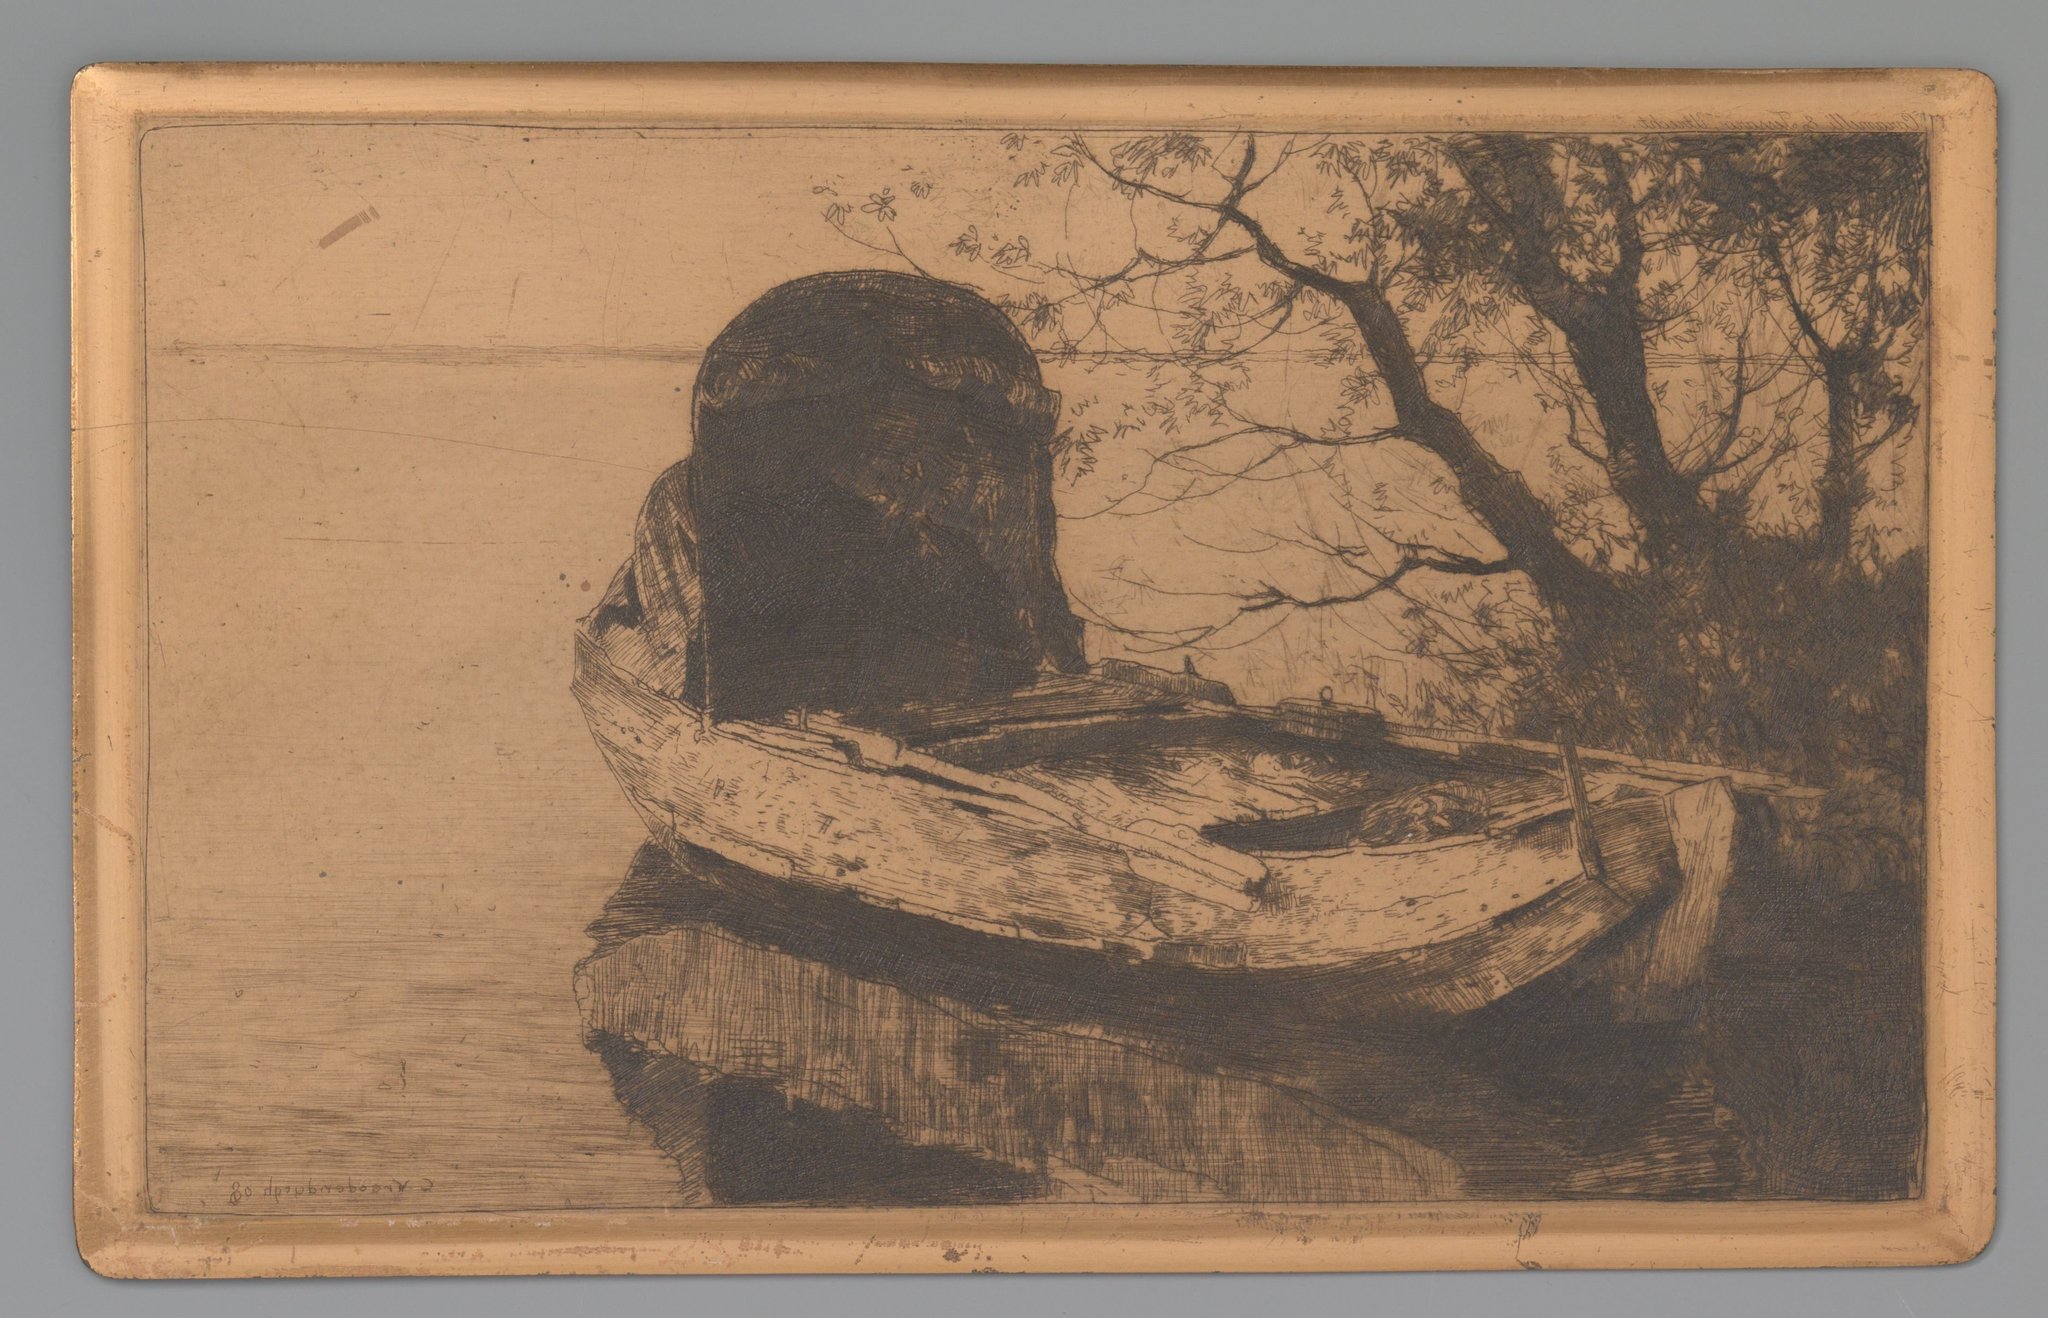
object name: copper plate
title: Boot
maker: cornelis vreedenburgh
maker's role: draughtsman, print maker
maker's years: 1880-1946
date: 1908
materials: copper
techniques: etching